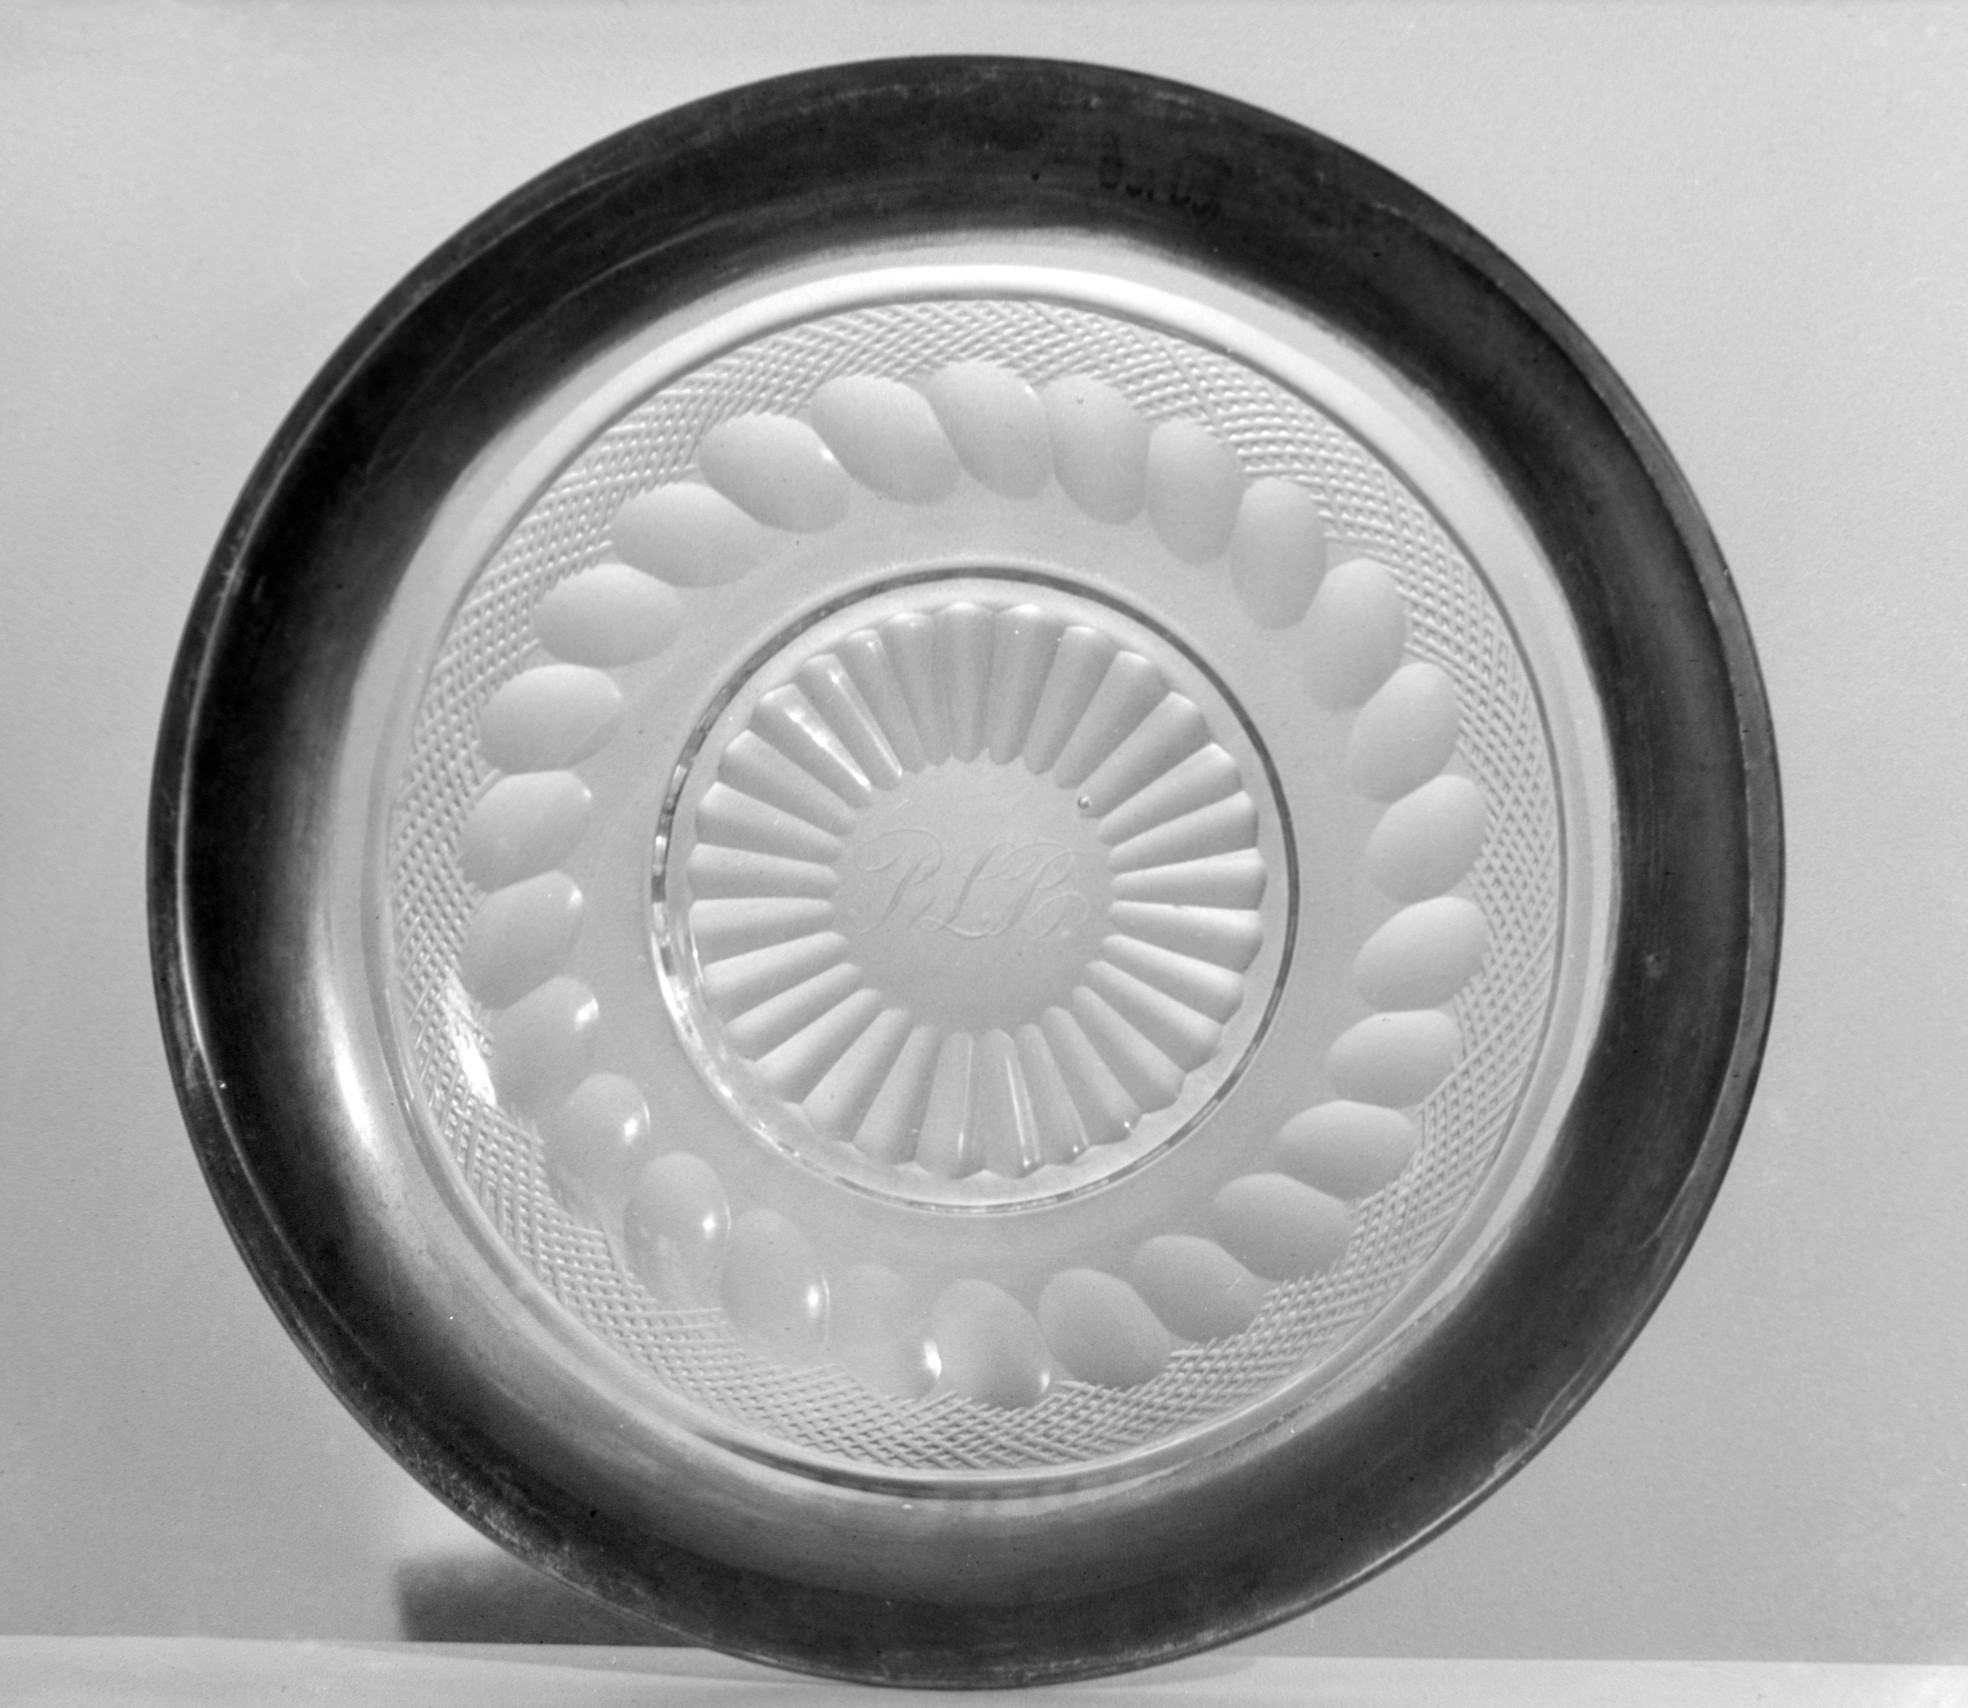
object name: saucer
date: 1821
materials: glass